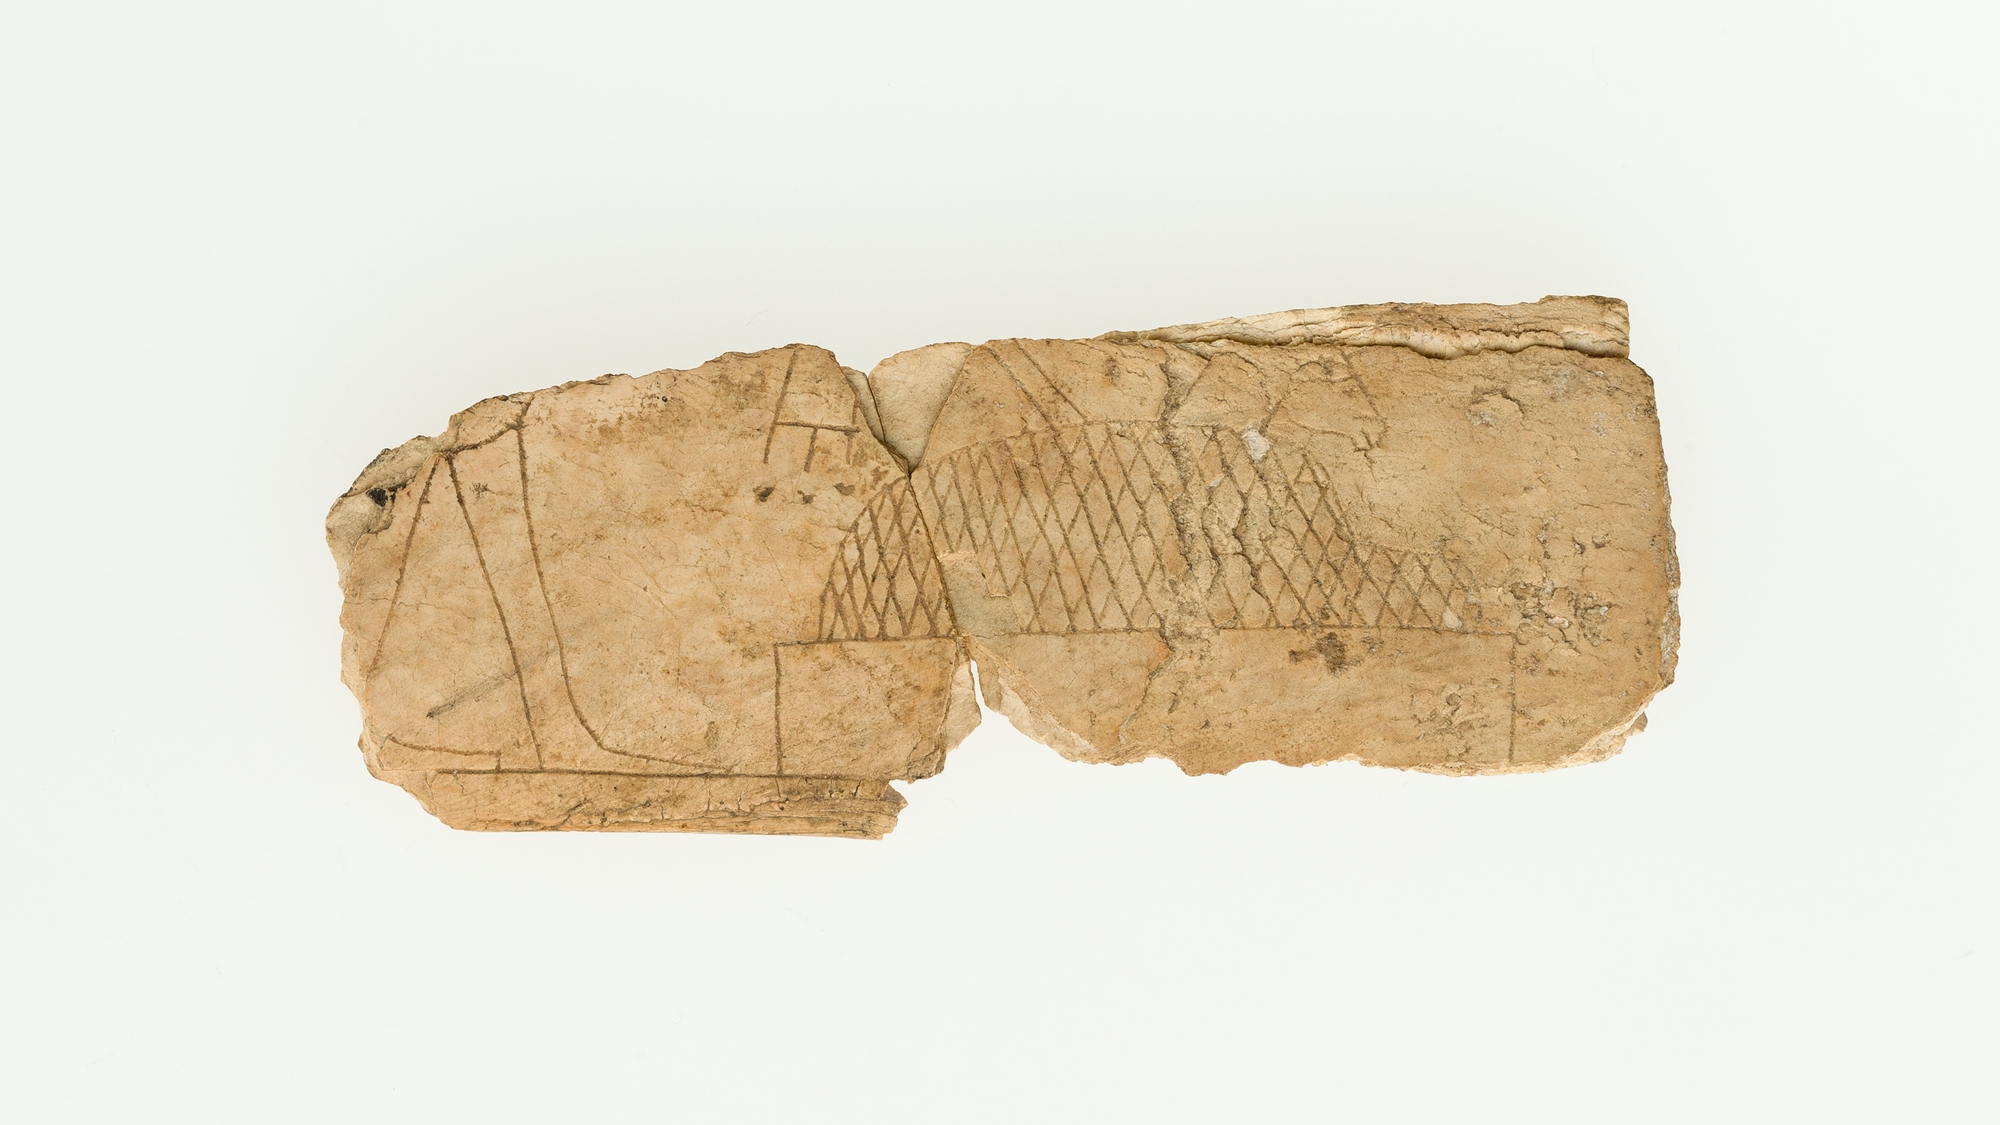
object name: magic wand fragment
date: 1981-1550 BCE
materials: ivory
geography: egypt